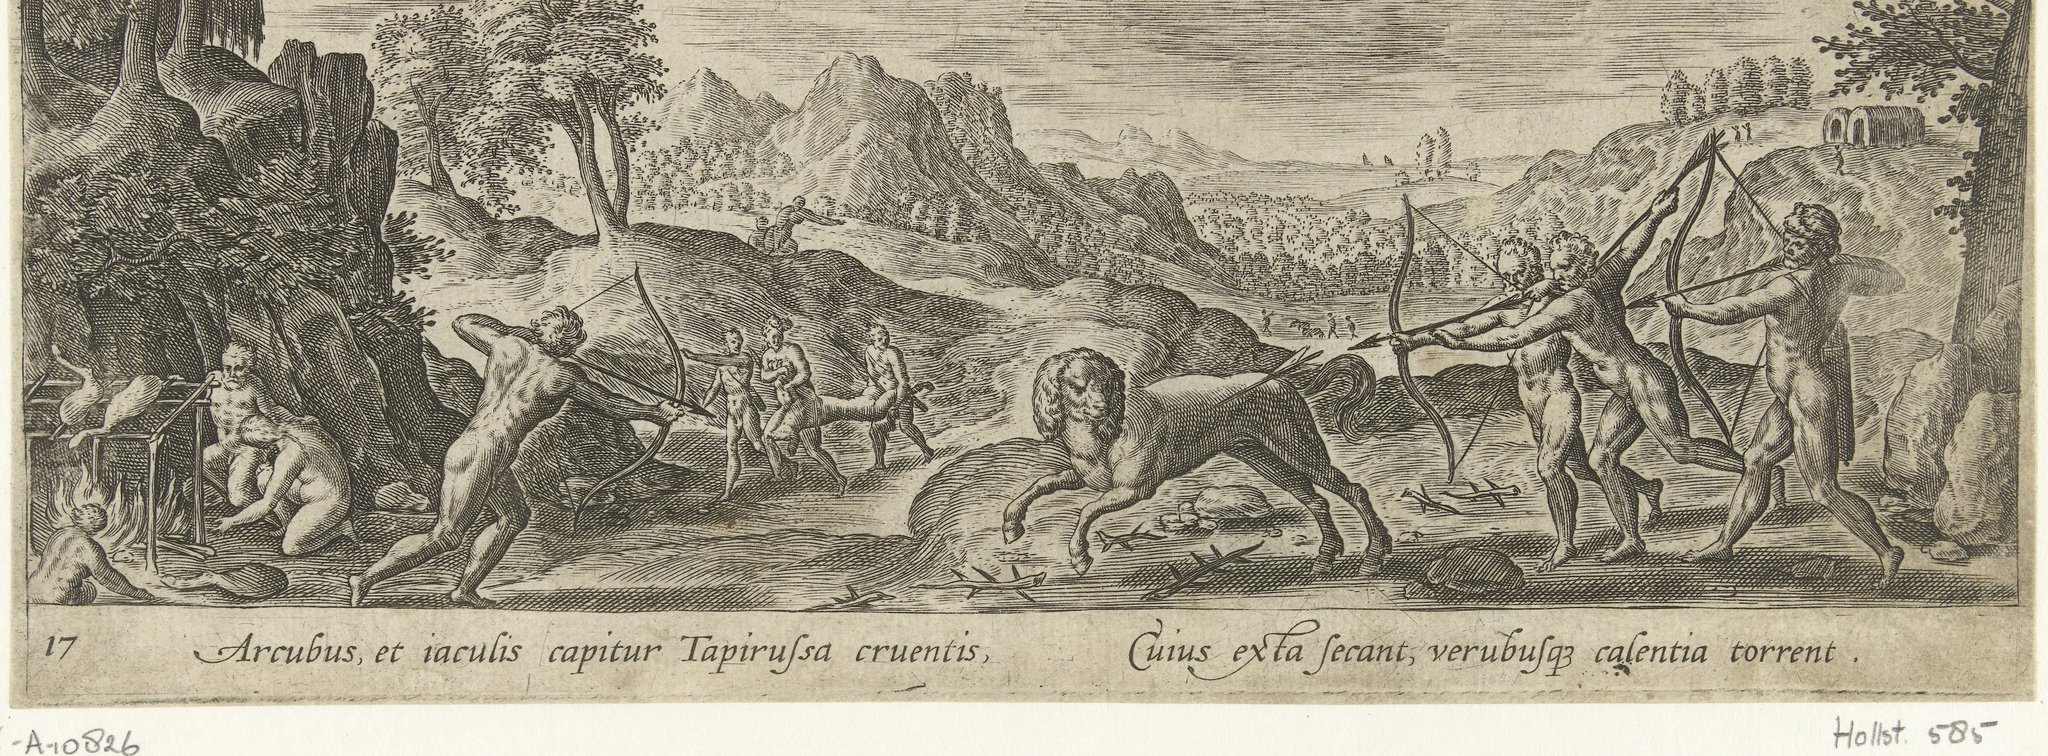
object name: print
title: Venationes, Piscationes et Aucupii Typi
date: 1582-1633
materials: paper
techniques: engraving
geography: antwerp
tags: native peoples of the americas, trunked animals: tapir, hunt ~ trunked animals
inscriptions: collector's mark: Lugt 2228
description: Oorspronkelijke bewoners van Amerika maken met pijl-en-boog jacht op een tapir. Eenmaal gedood wordt het beest meegenomen en opgegeten. De prent heeft een Latijns onderschrift en maakt deel uit van een serie van 54 prenten.